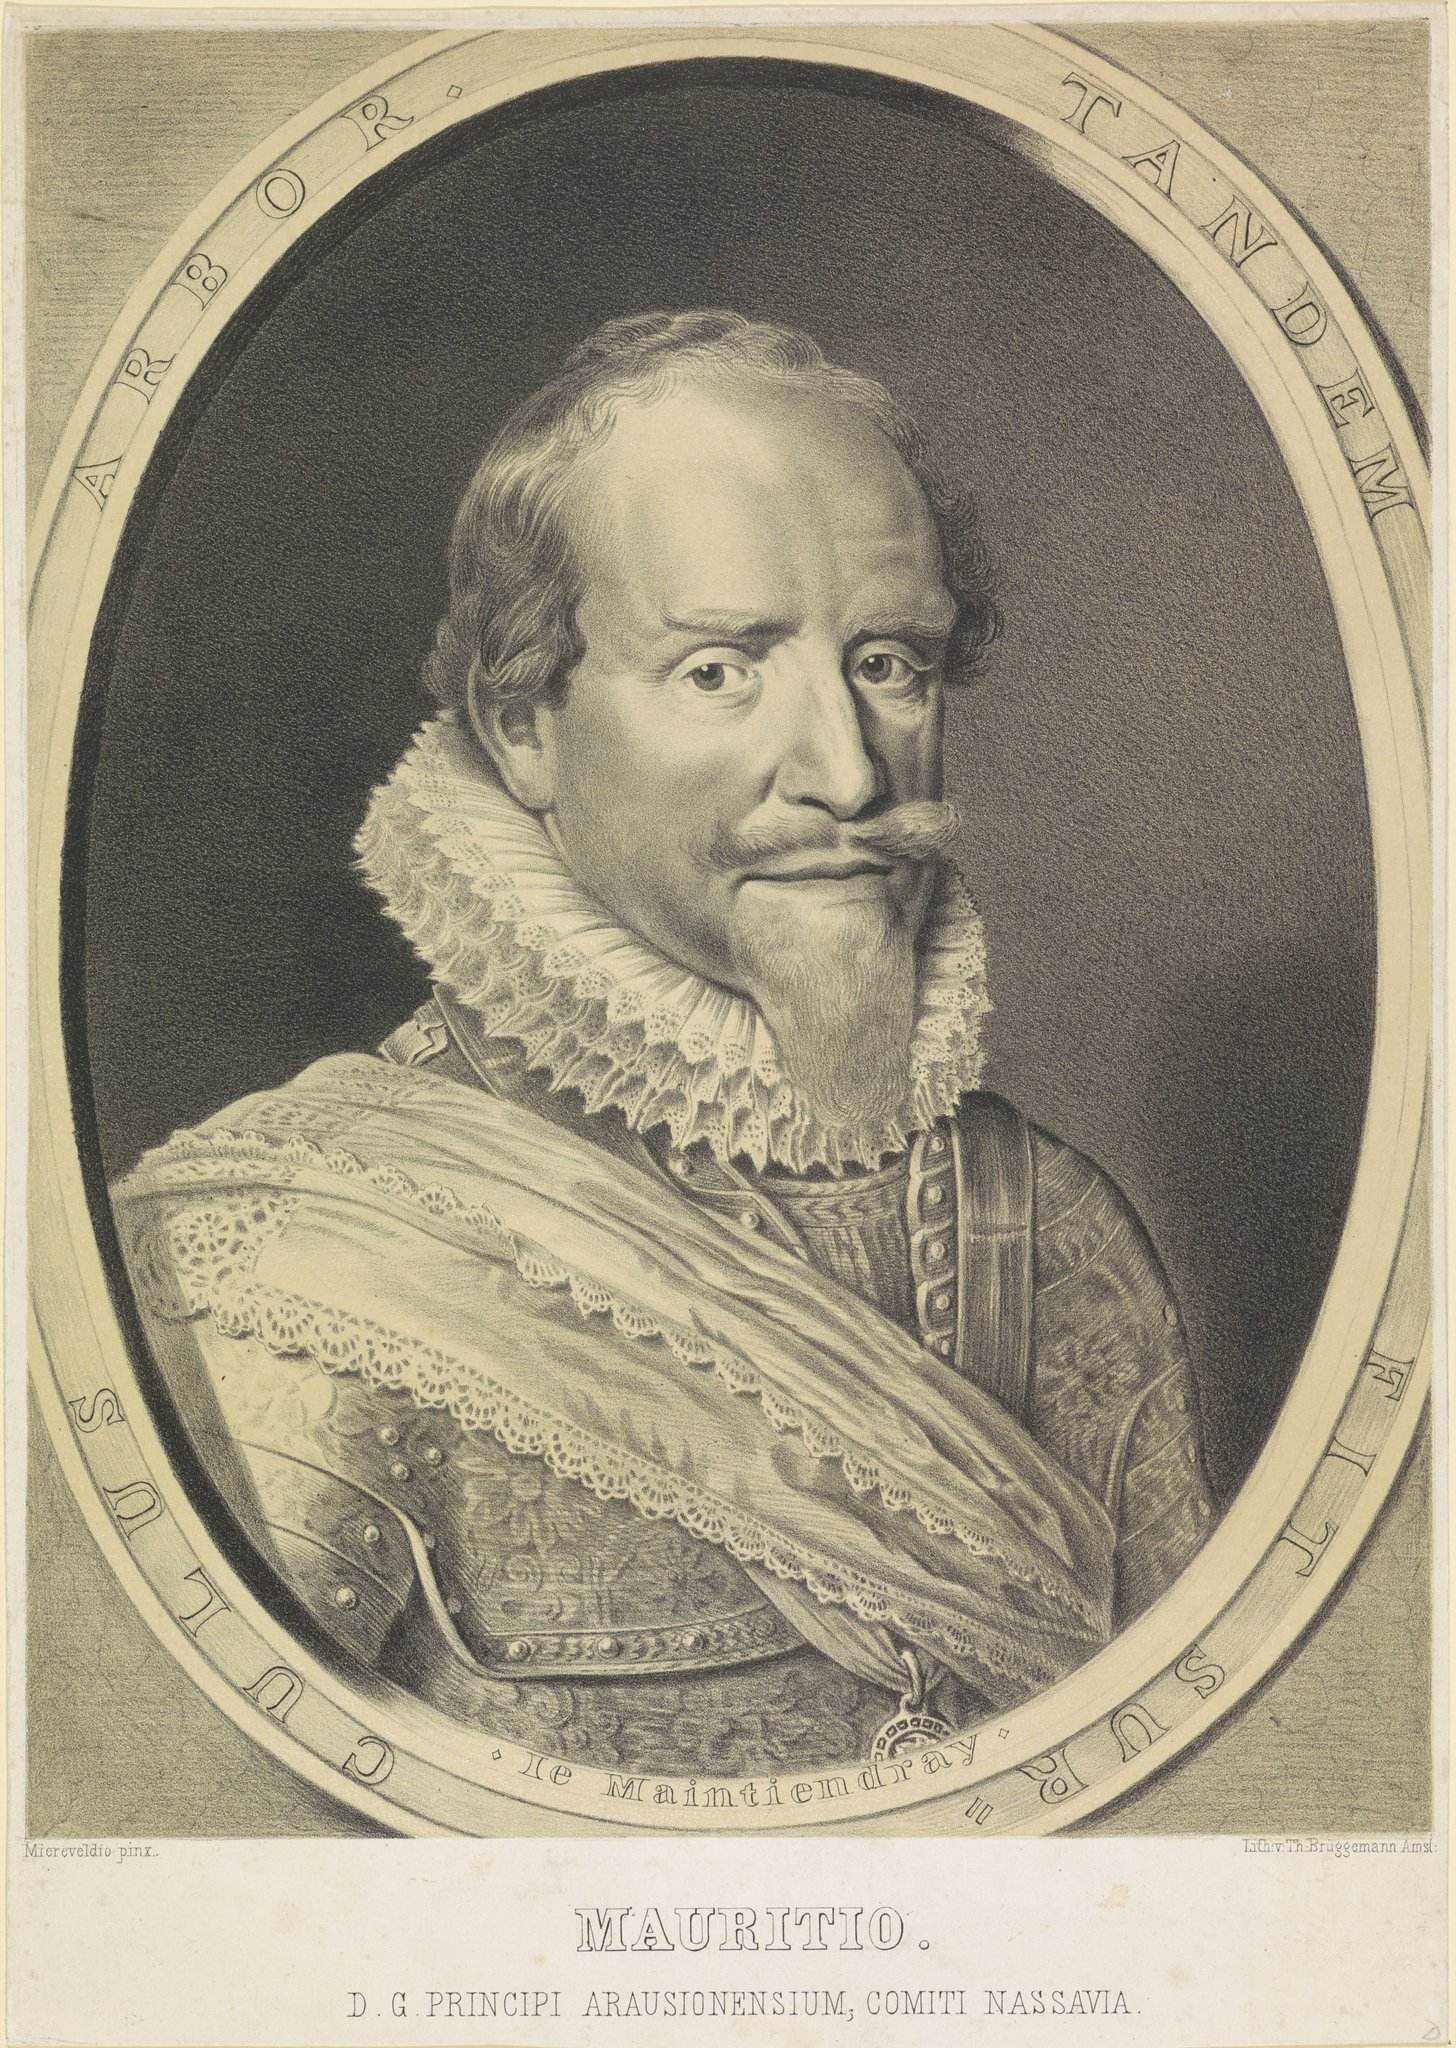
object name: print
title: Portret van Maurits, prins van Oranje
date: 1846-1888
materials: paper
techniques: tone lithography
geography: netherlands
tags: the hague, maurice (prince of orange), knighthood order (garter) - insignia of a knighthood order, e.g.: badge, chain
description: De hier vermelde titel verwijst naar de hoogst verkregen titel van de geportretteerde, niet per se naar de titel die de geportretteerde op deze voorstelling draagt.